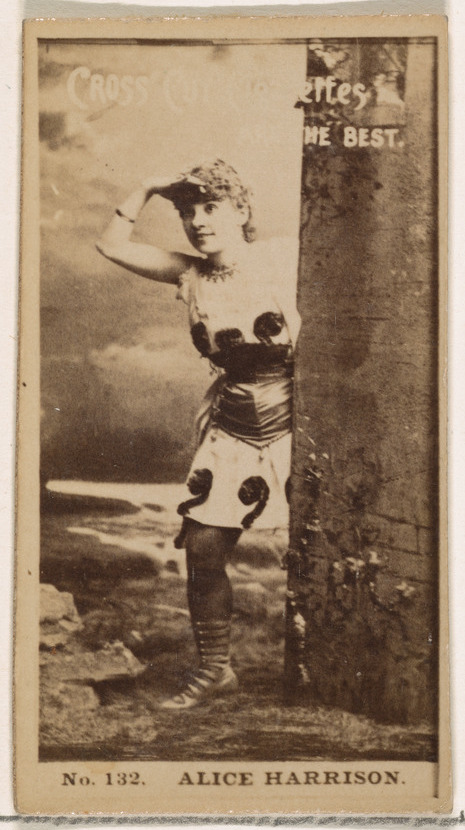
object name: print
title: Card Number 132, Alice Harrison, from the Actors and Actresses series (N145-2) issued by Duke Sons & Co. to promote Cross Cut Cigarettes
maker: w. duke, sons & co.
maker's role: publisher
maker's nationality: american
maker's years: 1870-1920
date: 1880-1889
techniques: albumen silver print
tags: portraits,women,actresses